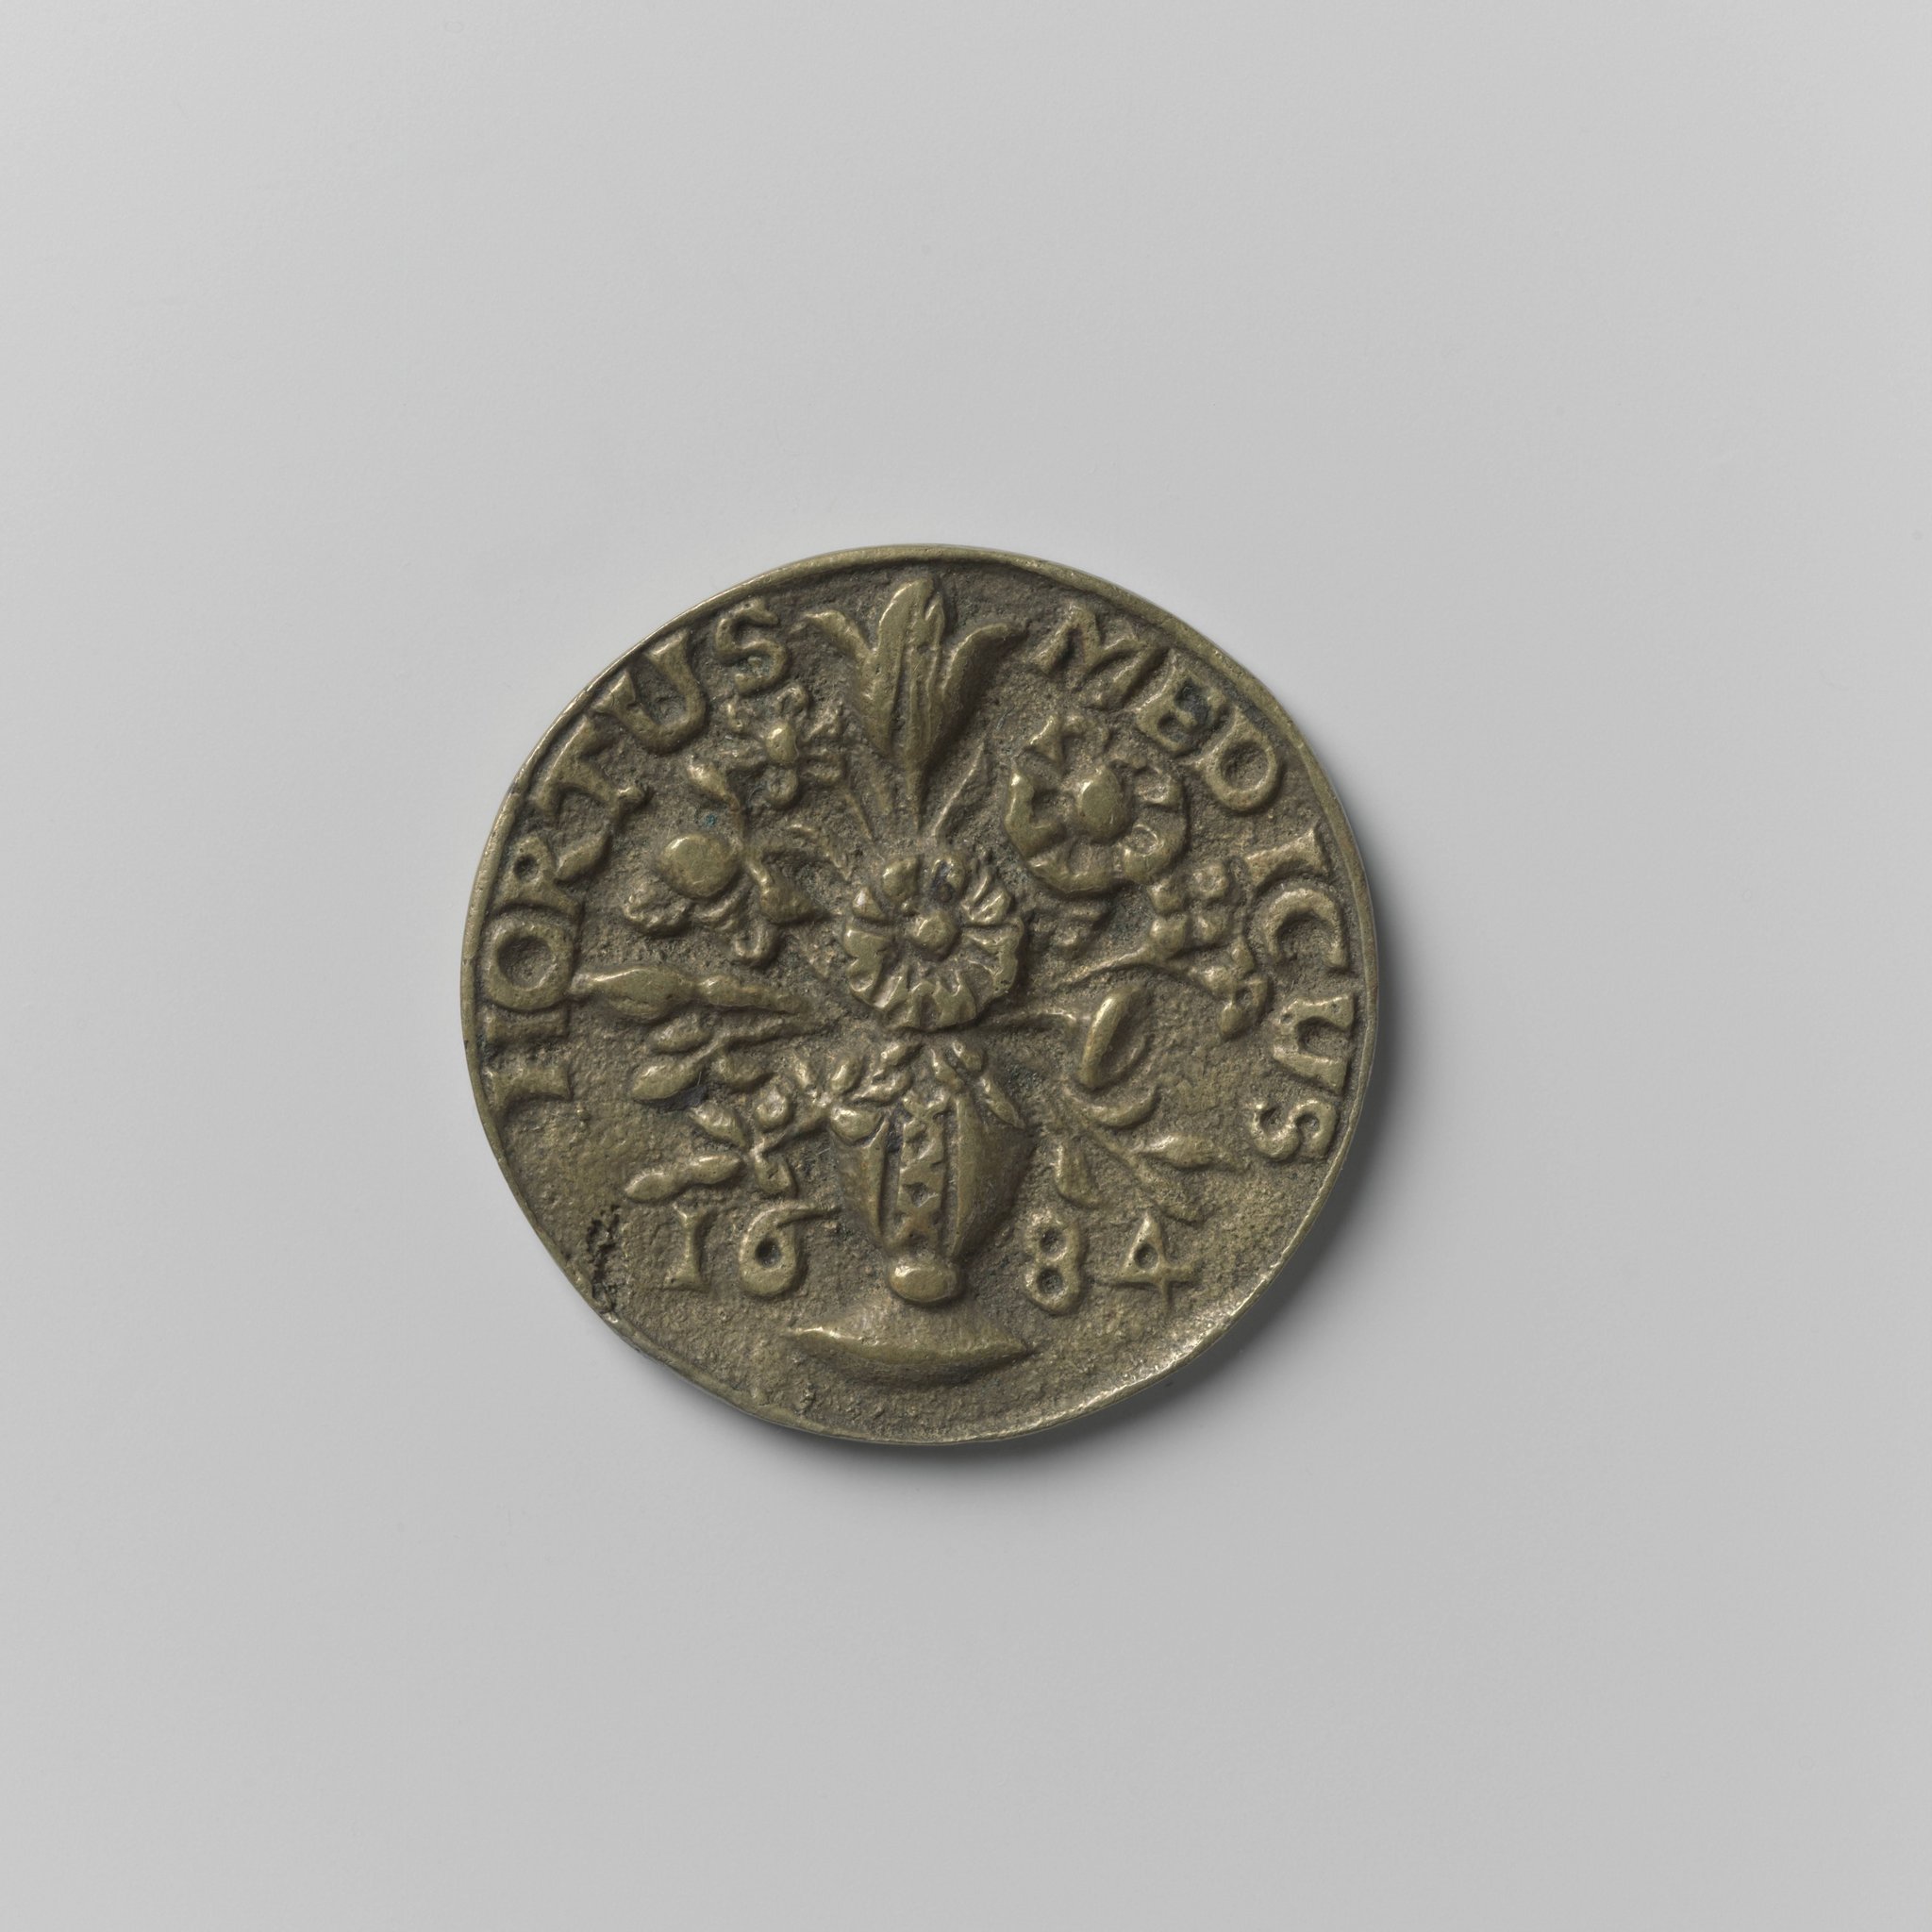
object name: medal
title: Collegium Medicum te Amsterdam, toegangspenning voor de hortus medicus voor apothekersleerling H.J.C.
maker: Anonymous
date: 1779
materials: brass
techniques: casting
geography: amsterdam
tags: collegium medicum, hortus medicus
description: Messing penning. Voorzijde: vaas met bloemen tussen jaartal; op vaas:wapenschild binnen omschrift. Keerzijde: monogram van letters H, J en C onder kroon boven jaartal